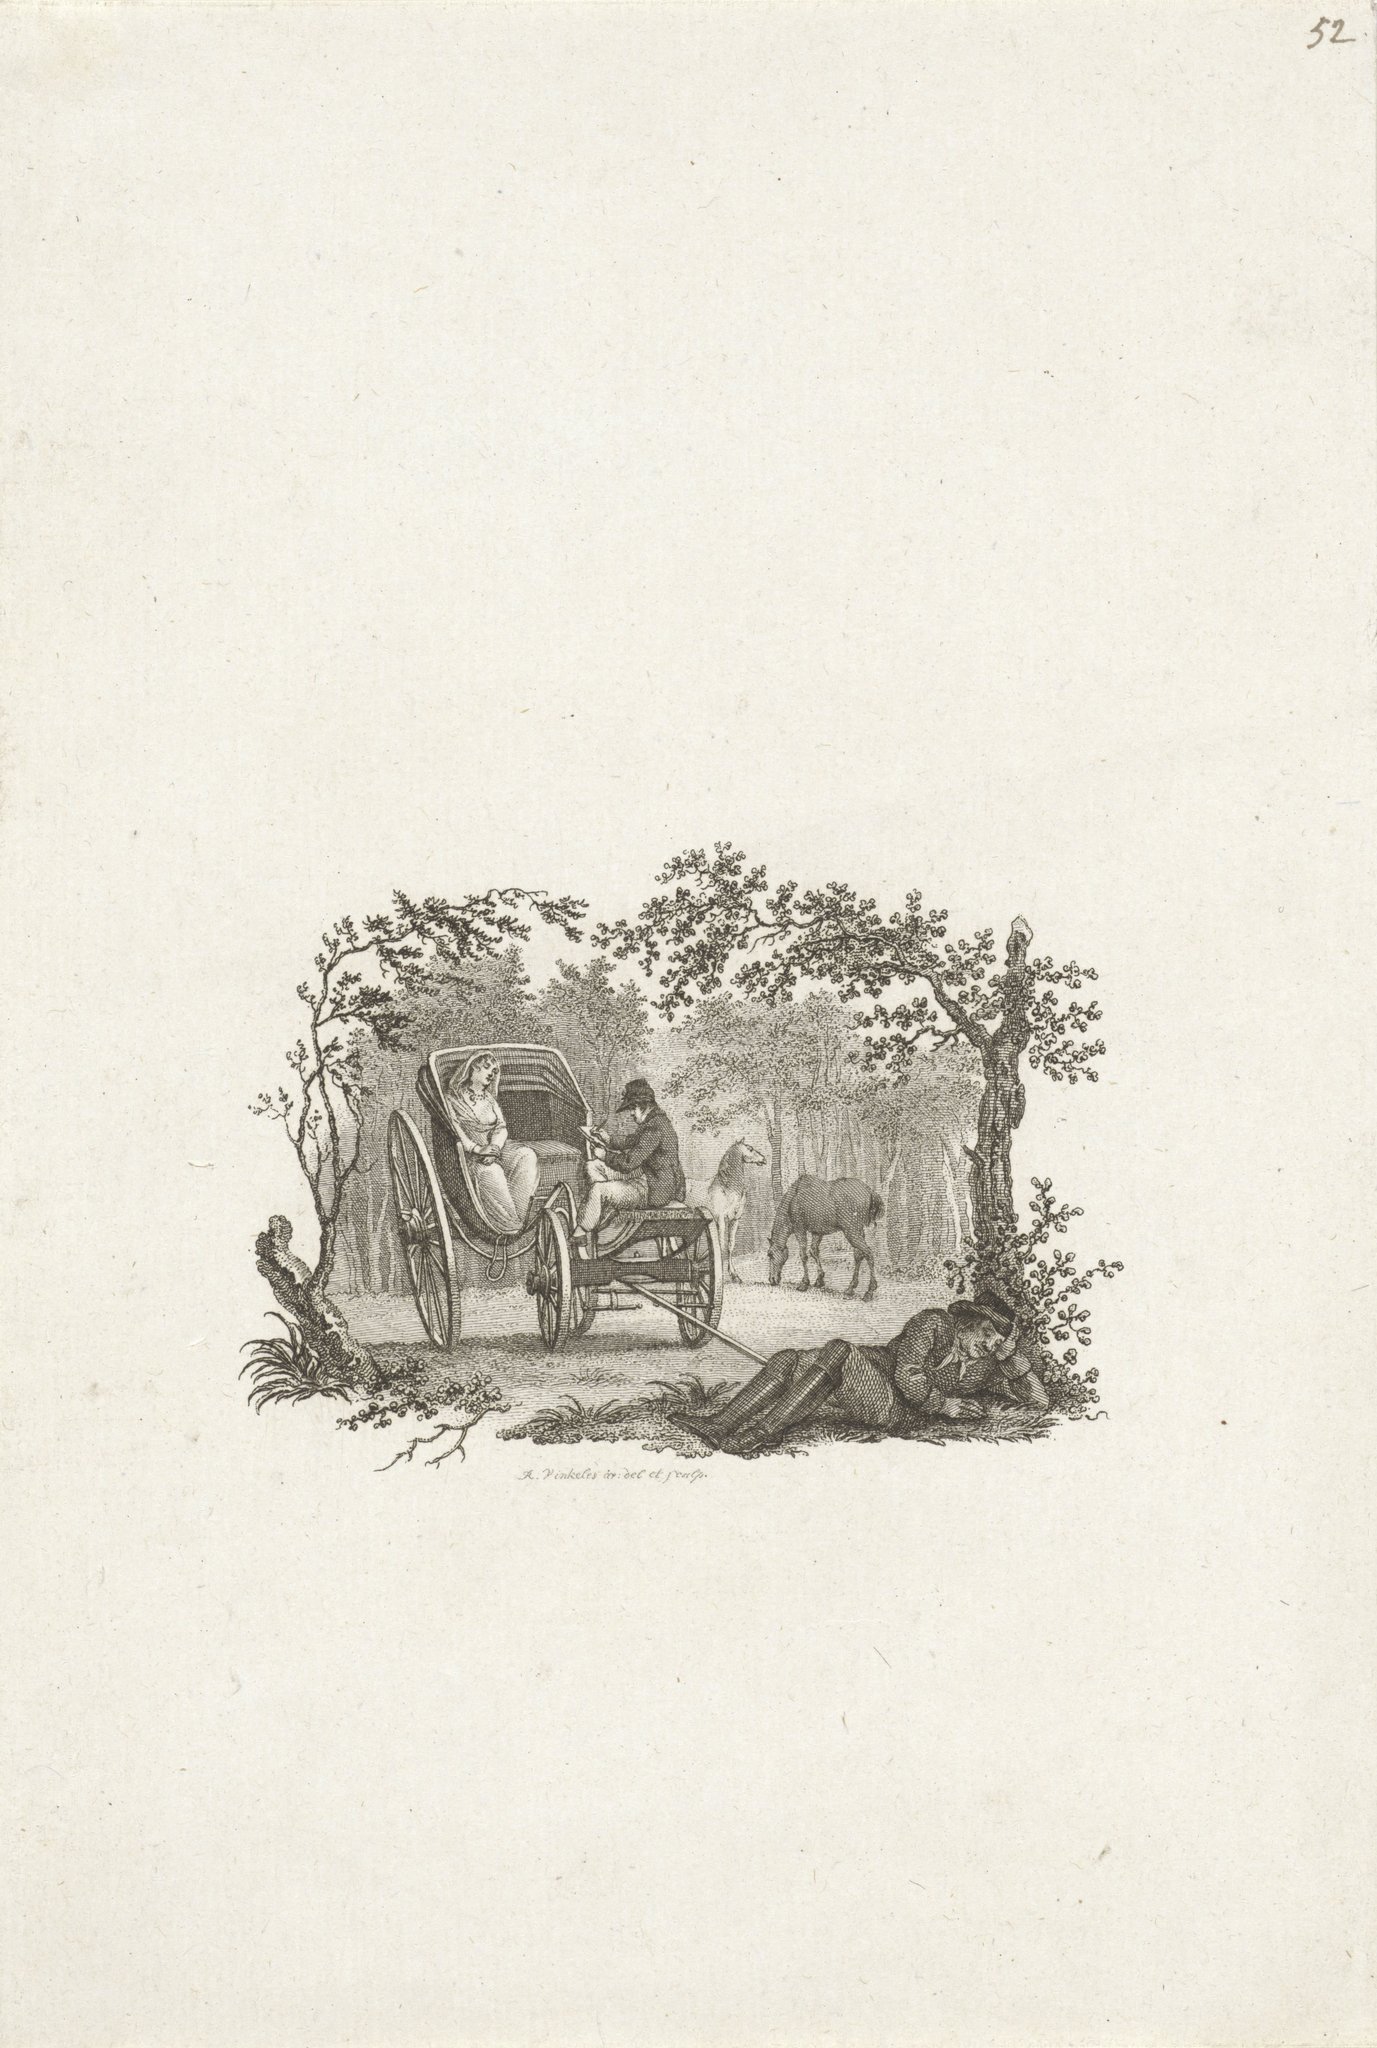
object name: print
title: Titelpagina: J.T. Hermes, 'Geschiedenis van den heer Leopold Kerker of Moeder Zoogster en Kind', 1810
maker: reinier vinkeles (i)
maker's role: draughtsman, print maker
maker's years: 1741-1816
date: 1751-1816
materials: paper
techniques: engraving, etching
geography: amsterdam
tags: art (+ working from live model), forest, wood, horse, four-wheeled vehicle drawn by two animals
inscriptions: collector's mark: Lugt 2228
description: Proefdruk van titelpagina voor: Hermes, Johann Timotheus. Geschiedenis van den heer Leopold Kerker of Moeder Zoogster en Kind. Haarlem: Adriaan Pietersz. Loosjes, 1810.